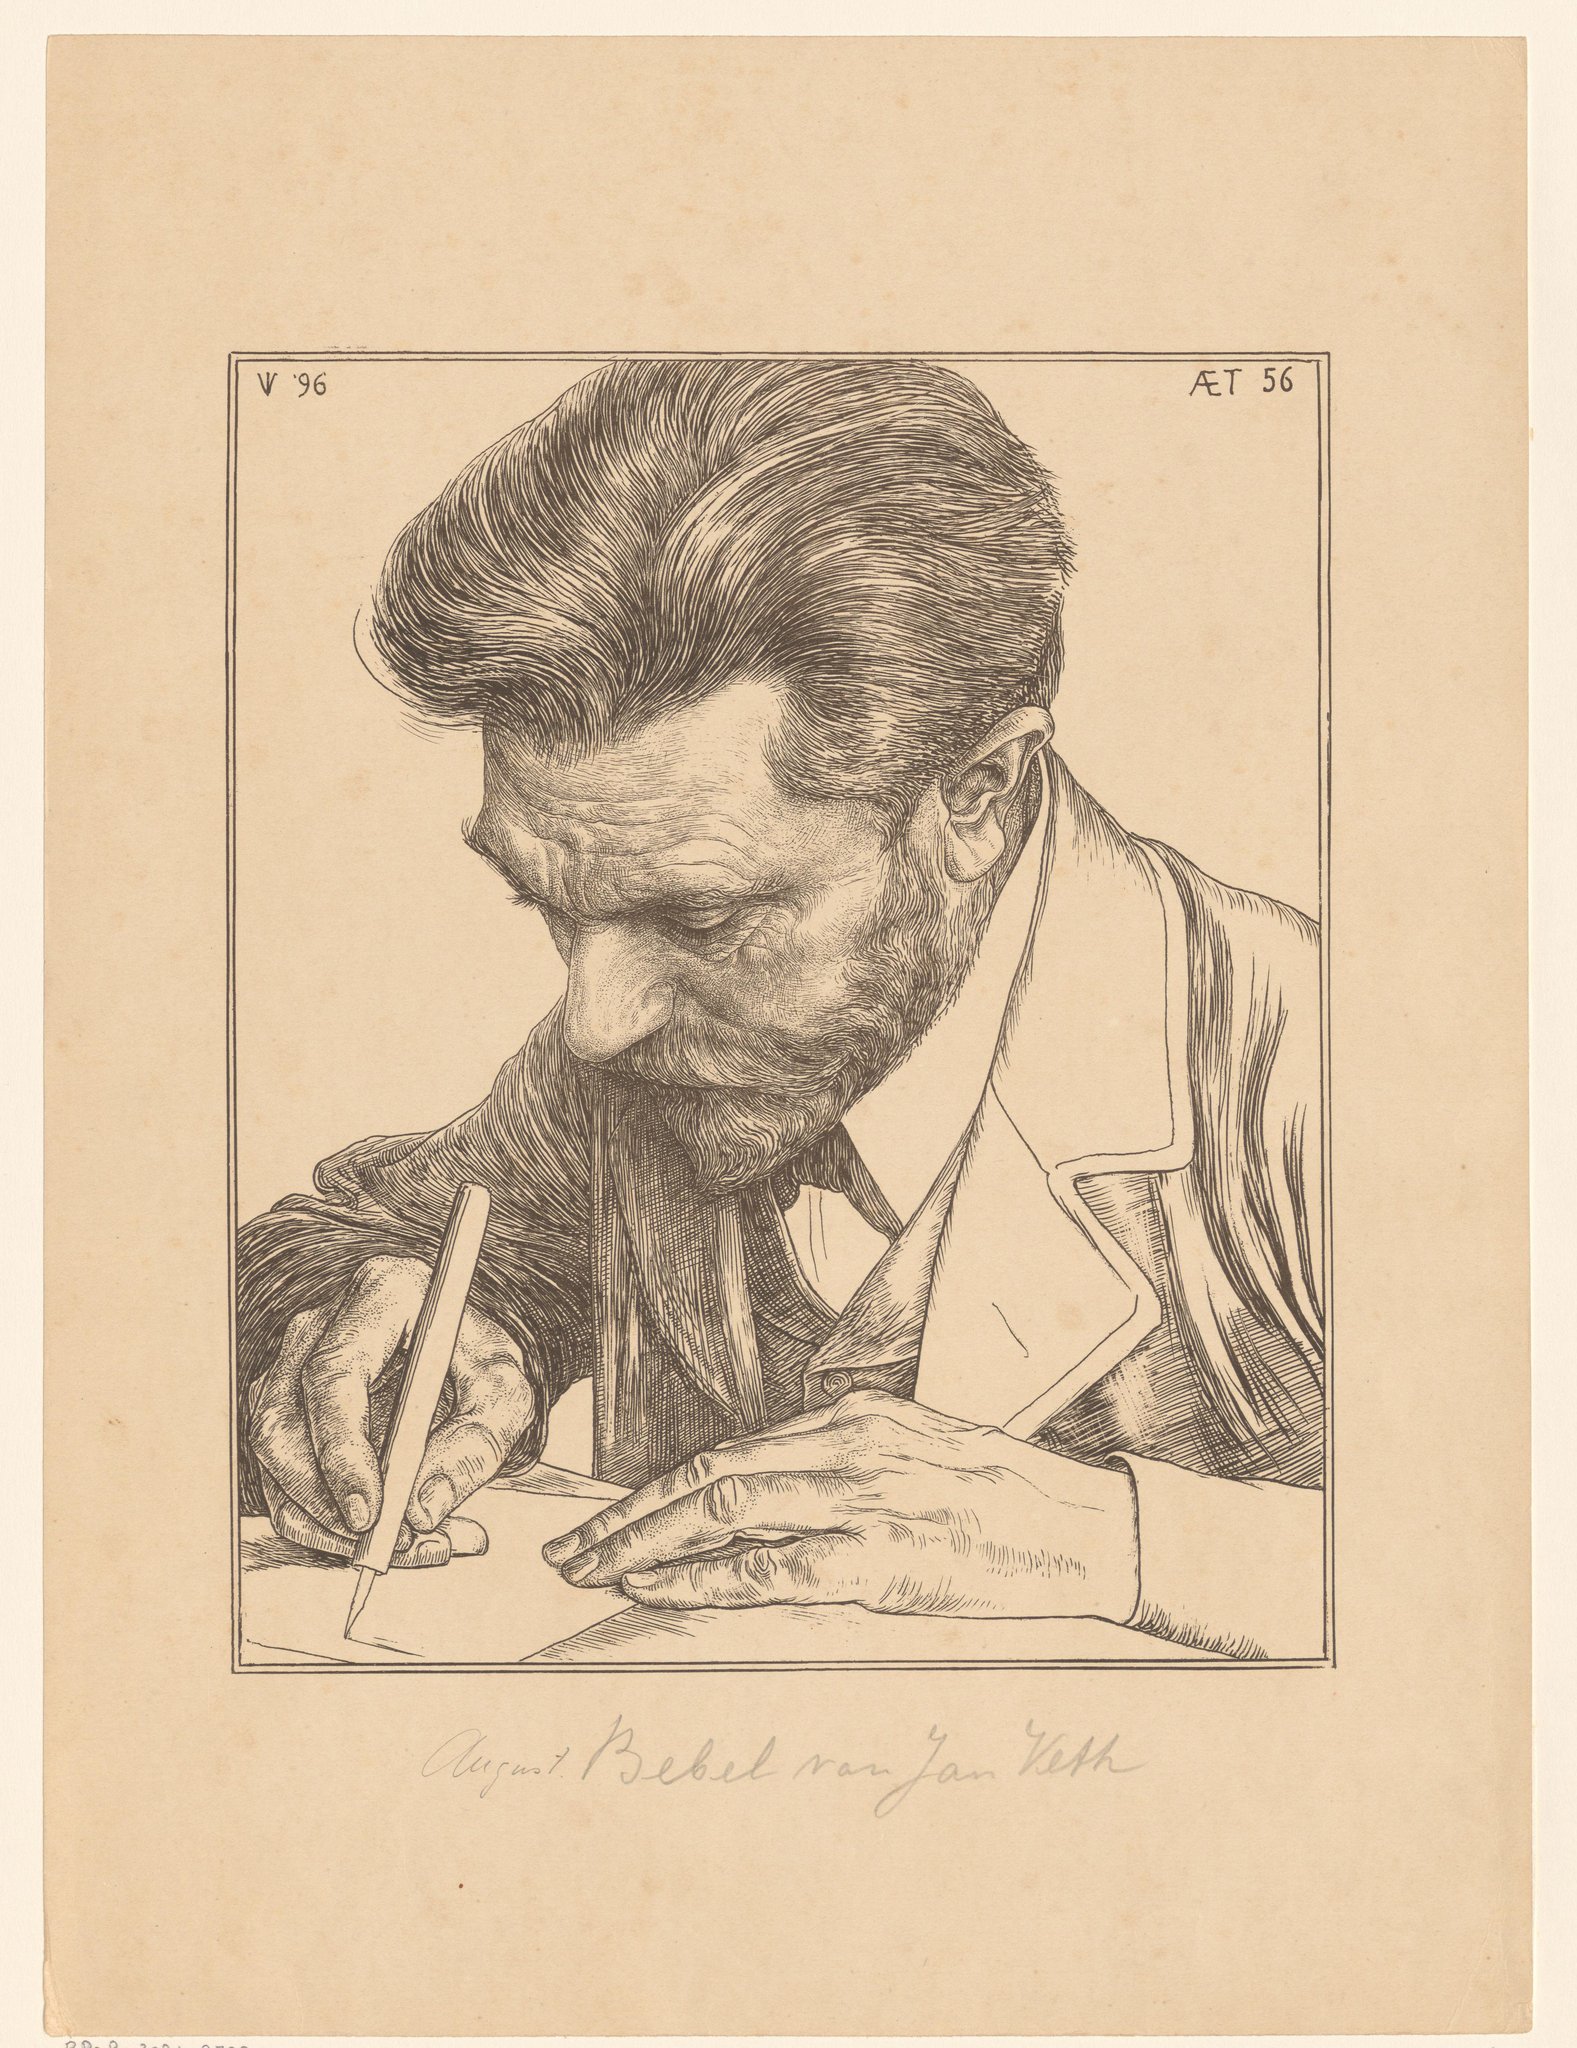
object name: print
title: Portret van August Bebel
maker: jan veth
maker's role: designer, draughtsman, painter, print maker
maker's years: 1864-1925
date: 1896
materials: paper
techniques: lithograph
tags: politician, writing tools, historical persons, politician, e.g. party leader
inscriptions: collector's mark: Lugt 2228